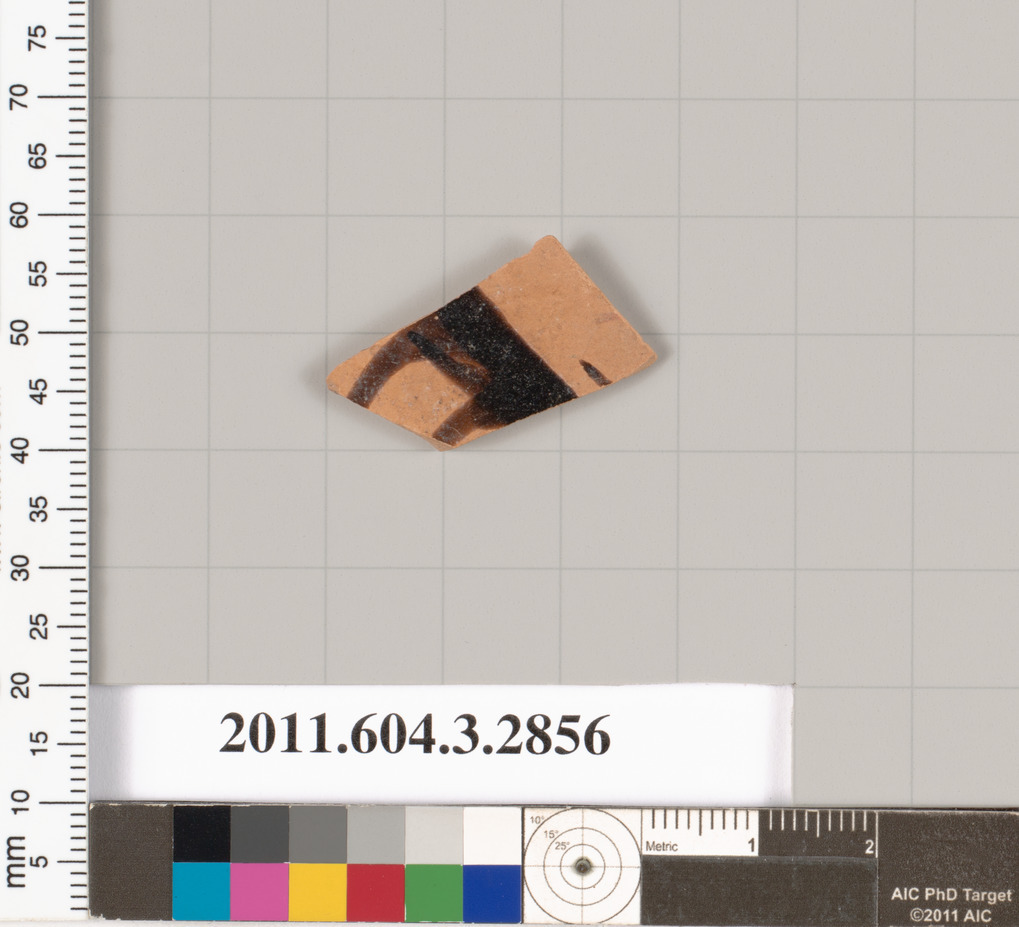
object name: undetermined closed shape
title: Terracotta fragment of a closed shape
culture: greek, attic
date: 534-468 BCE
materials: terracotta